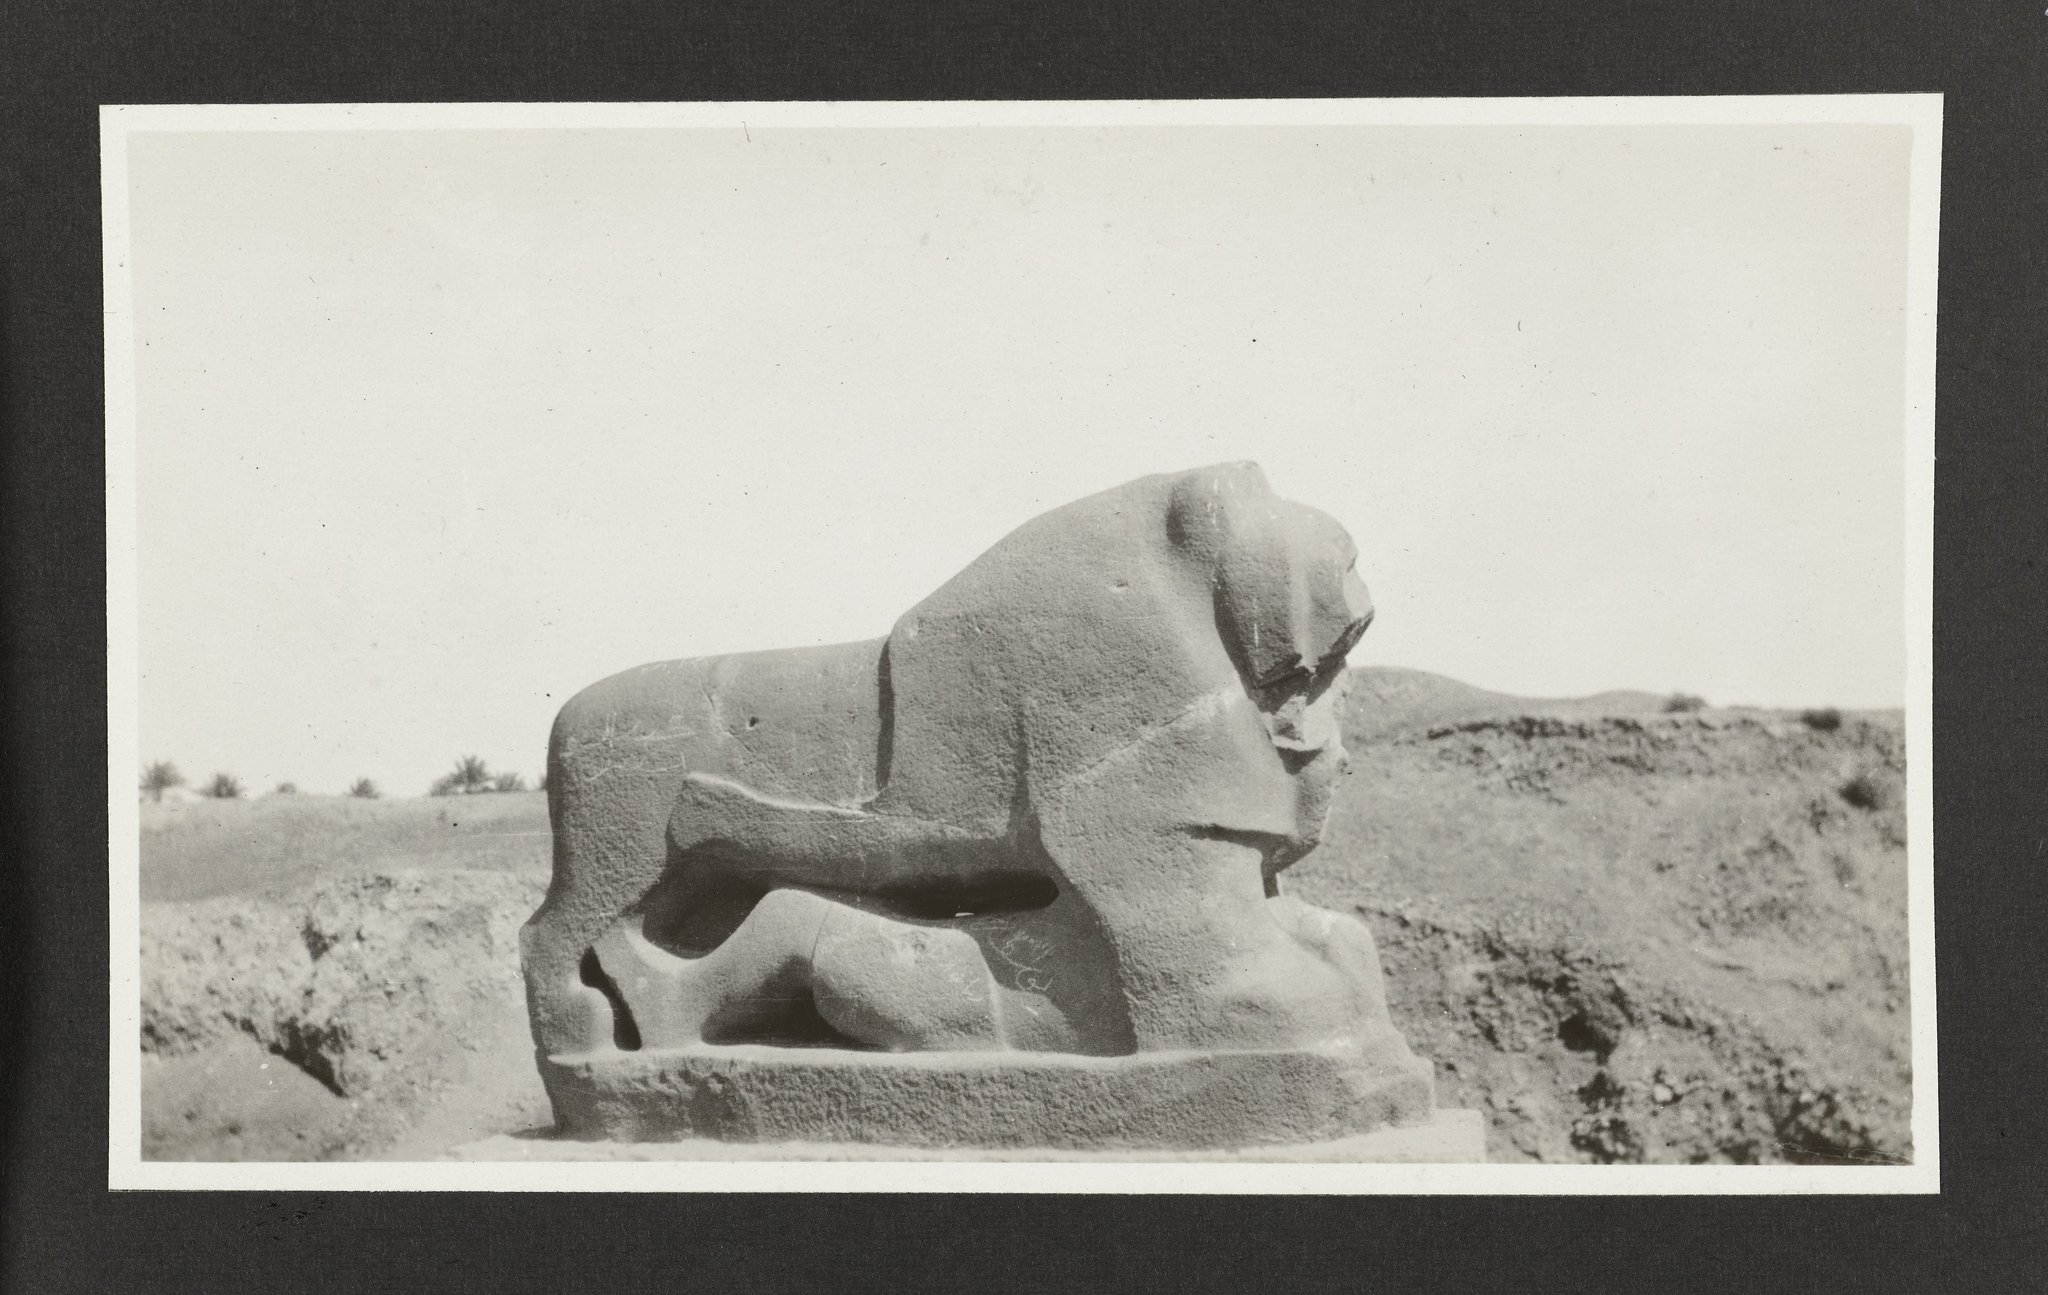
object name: photograph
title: Beeld van leeuw en man te Babylon, Hillah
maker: a.g.a. van eelde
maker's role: engineer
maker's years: 1862-1950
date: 1925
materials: cardboard, paper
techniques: gelatin silver print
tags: irak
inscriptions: number: ‘7.’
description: Titel op object afkomstig uit inventaris (Verklaring der Photo's) behorend bij het album.